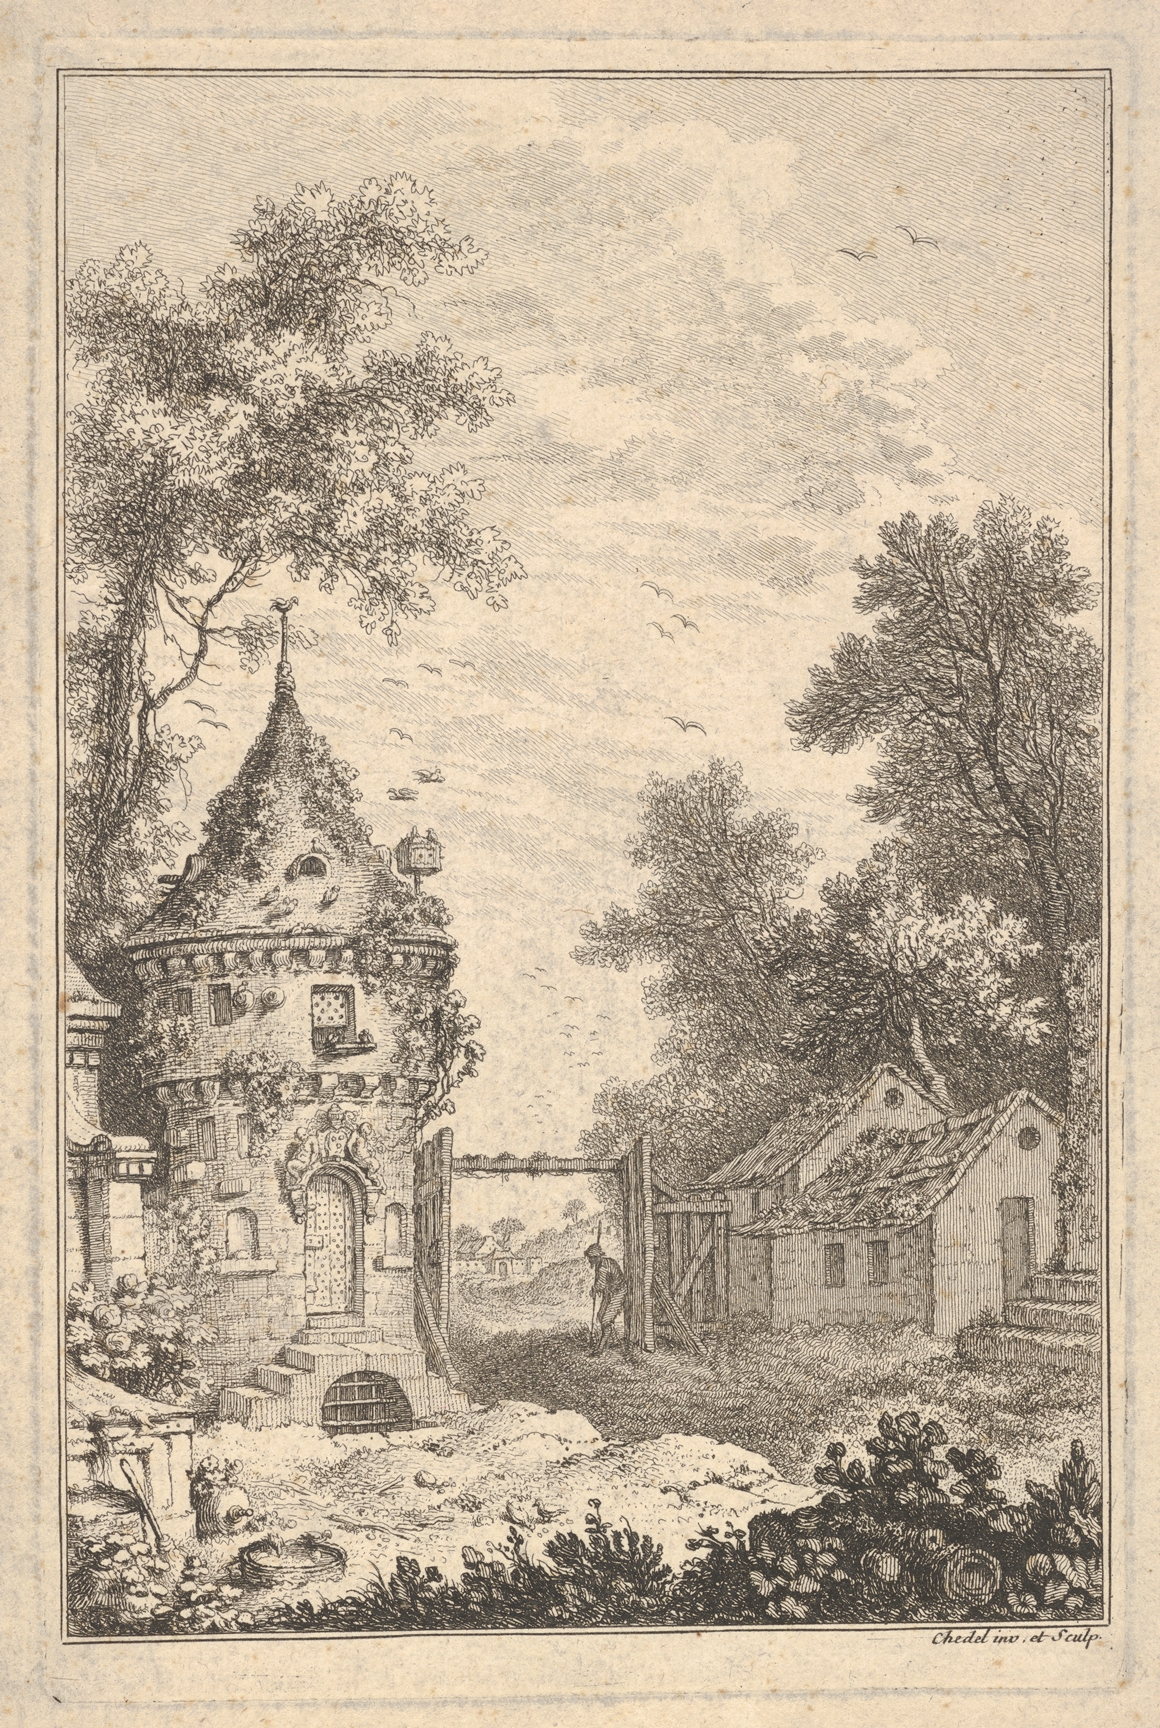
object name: print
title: Garden Scene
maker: quentin pierre chedel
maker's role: artist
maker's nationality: french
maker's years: 1705-1763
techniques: engraving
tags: architecture,gardens,trees